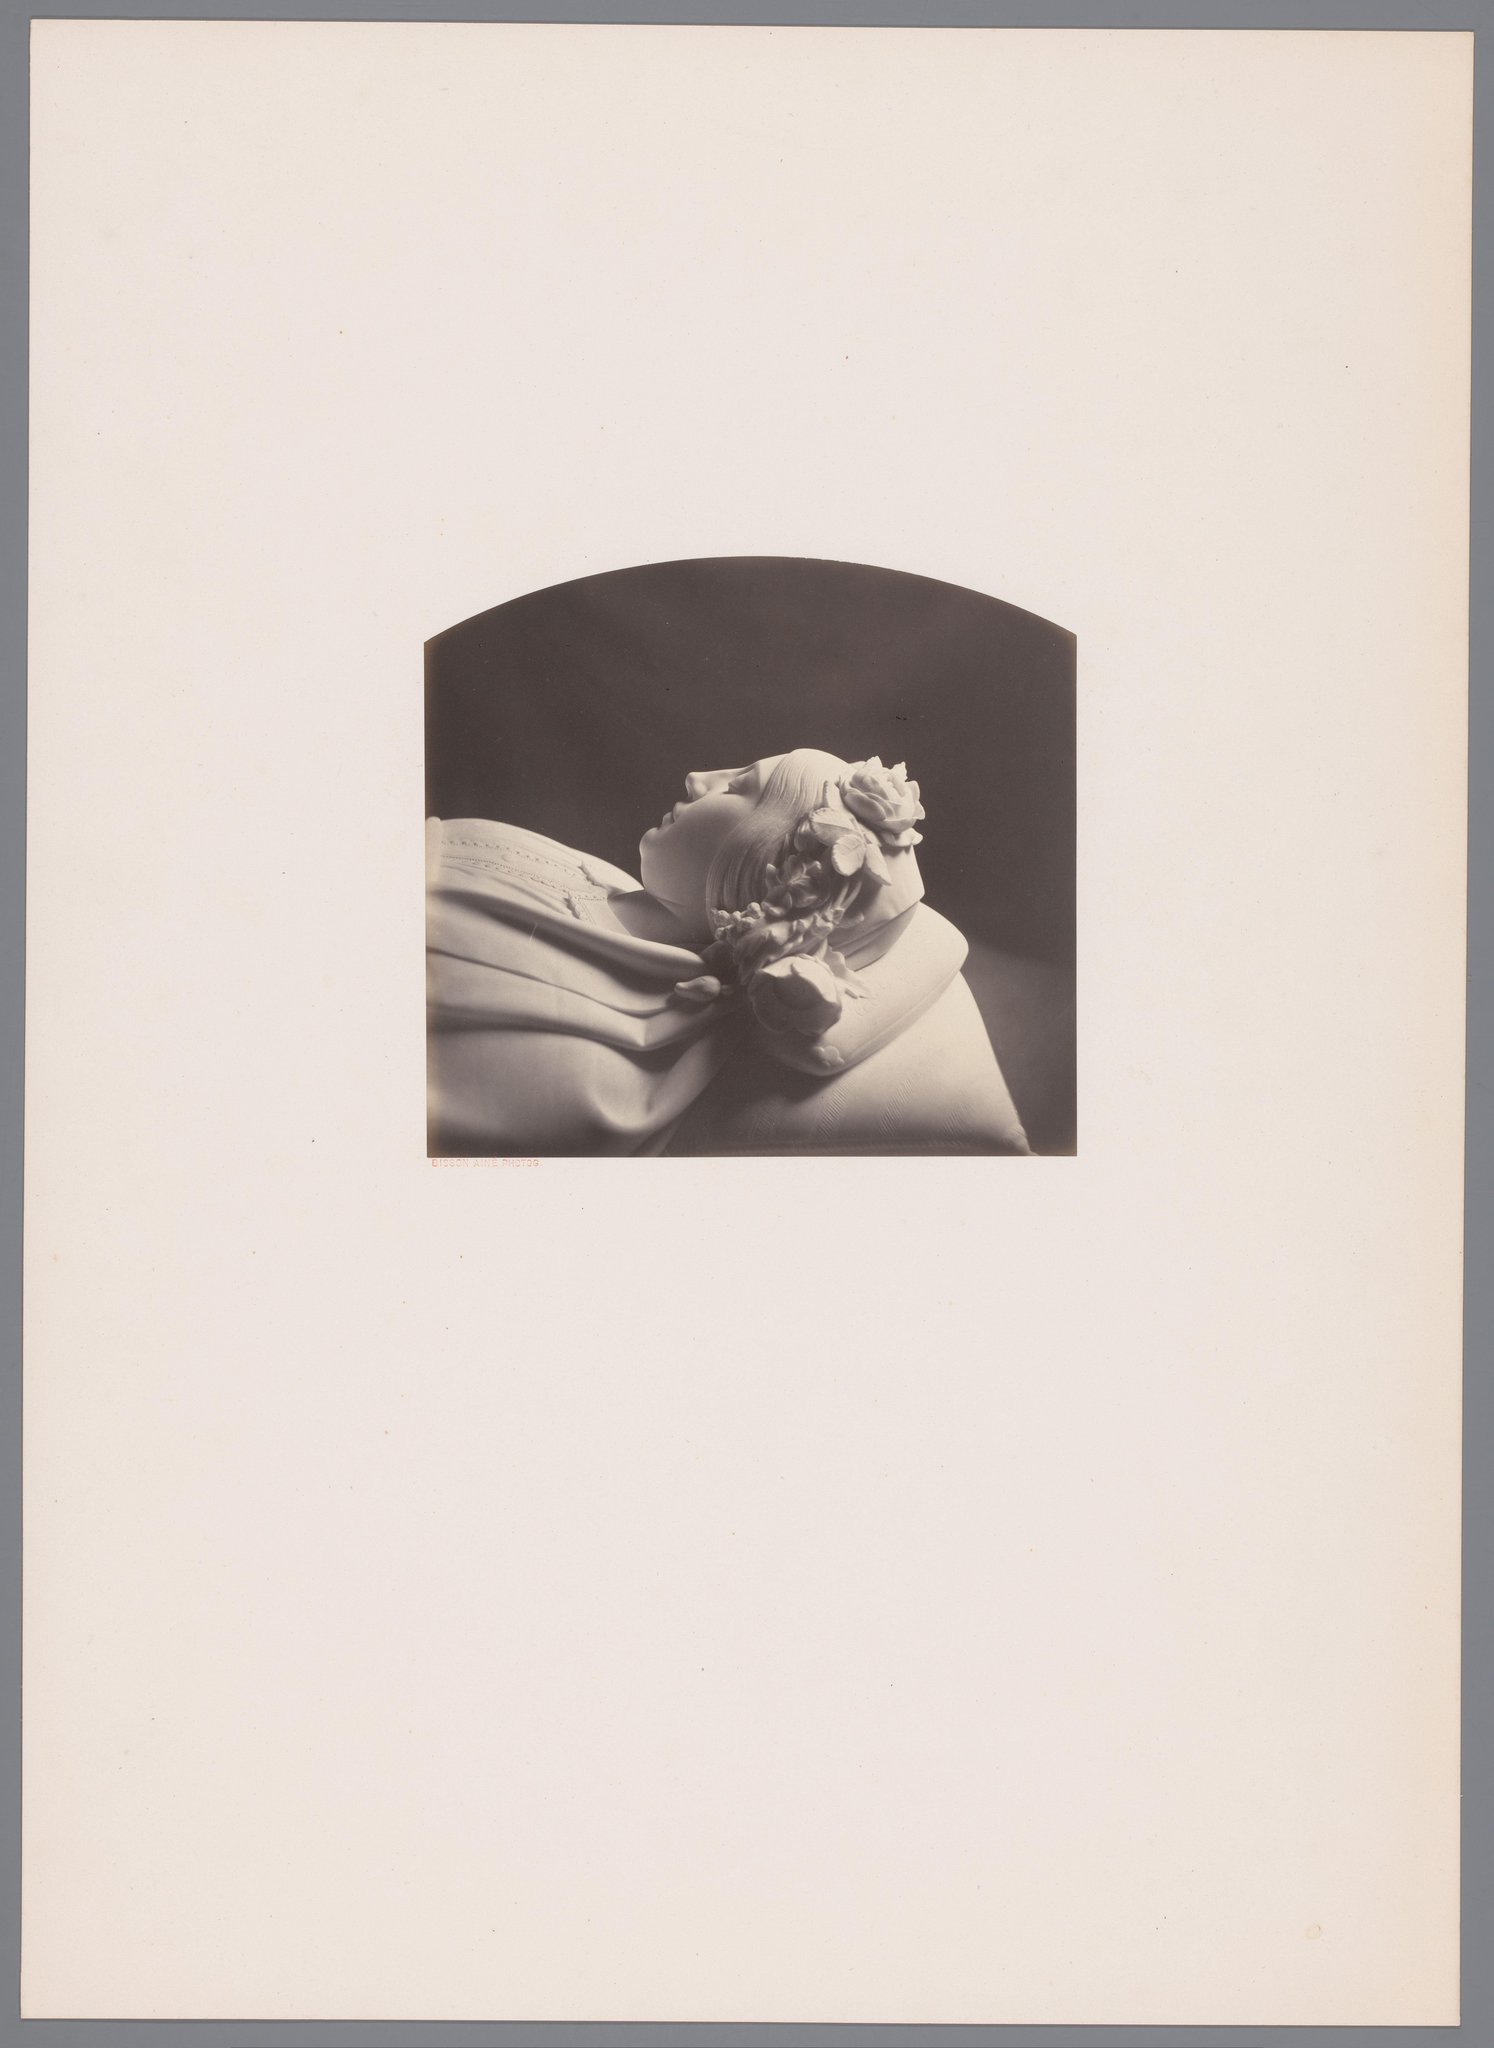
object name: photograph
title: Graftombe van Duchesse de Luynes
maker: louis-auguste bisson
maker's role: fotograaf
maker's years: 1814-1876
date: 1860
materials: cardboard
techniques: albumen print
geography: france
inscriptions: check stamp: ‘Provenance Estate Duc de Luynes’